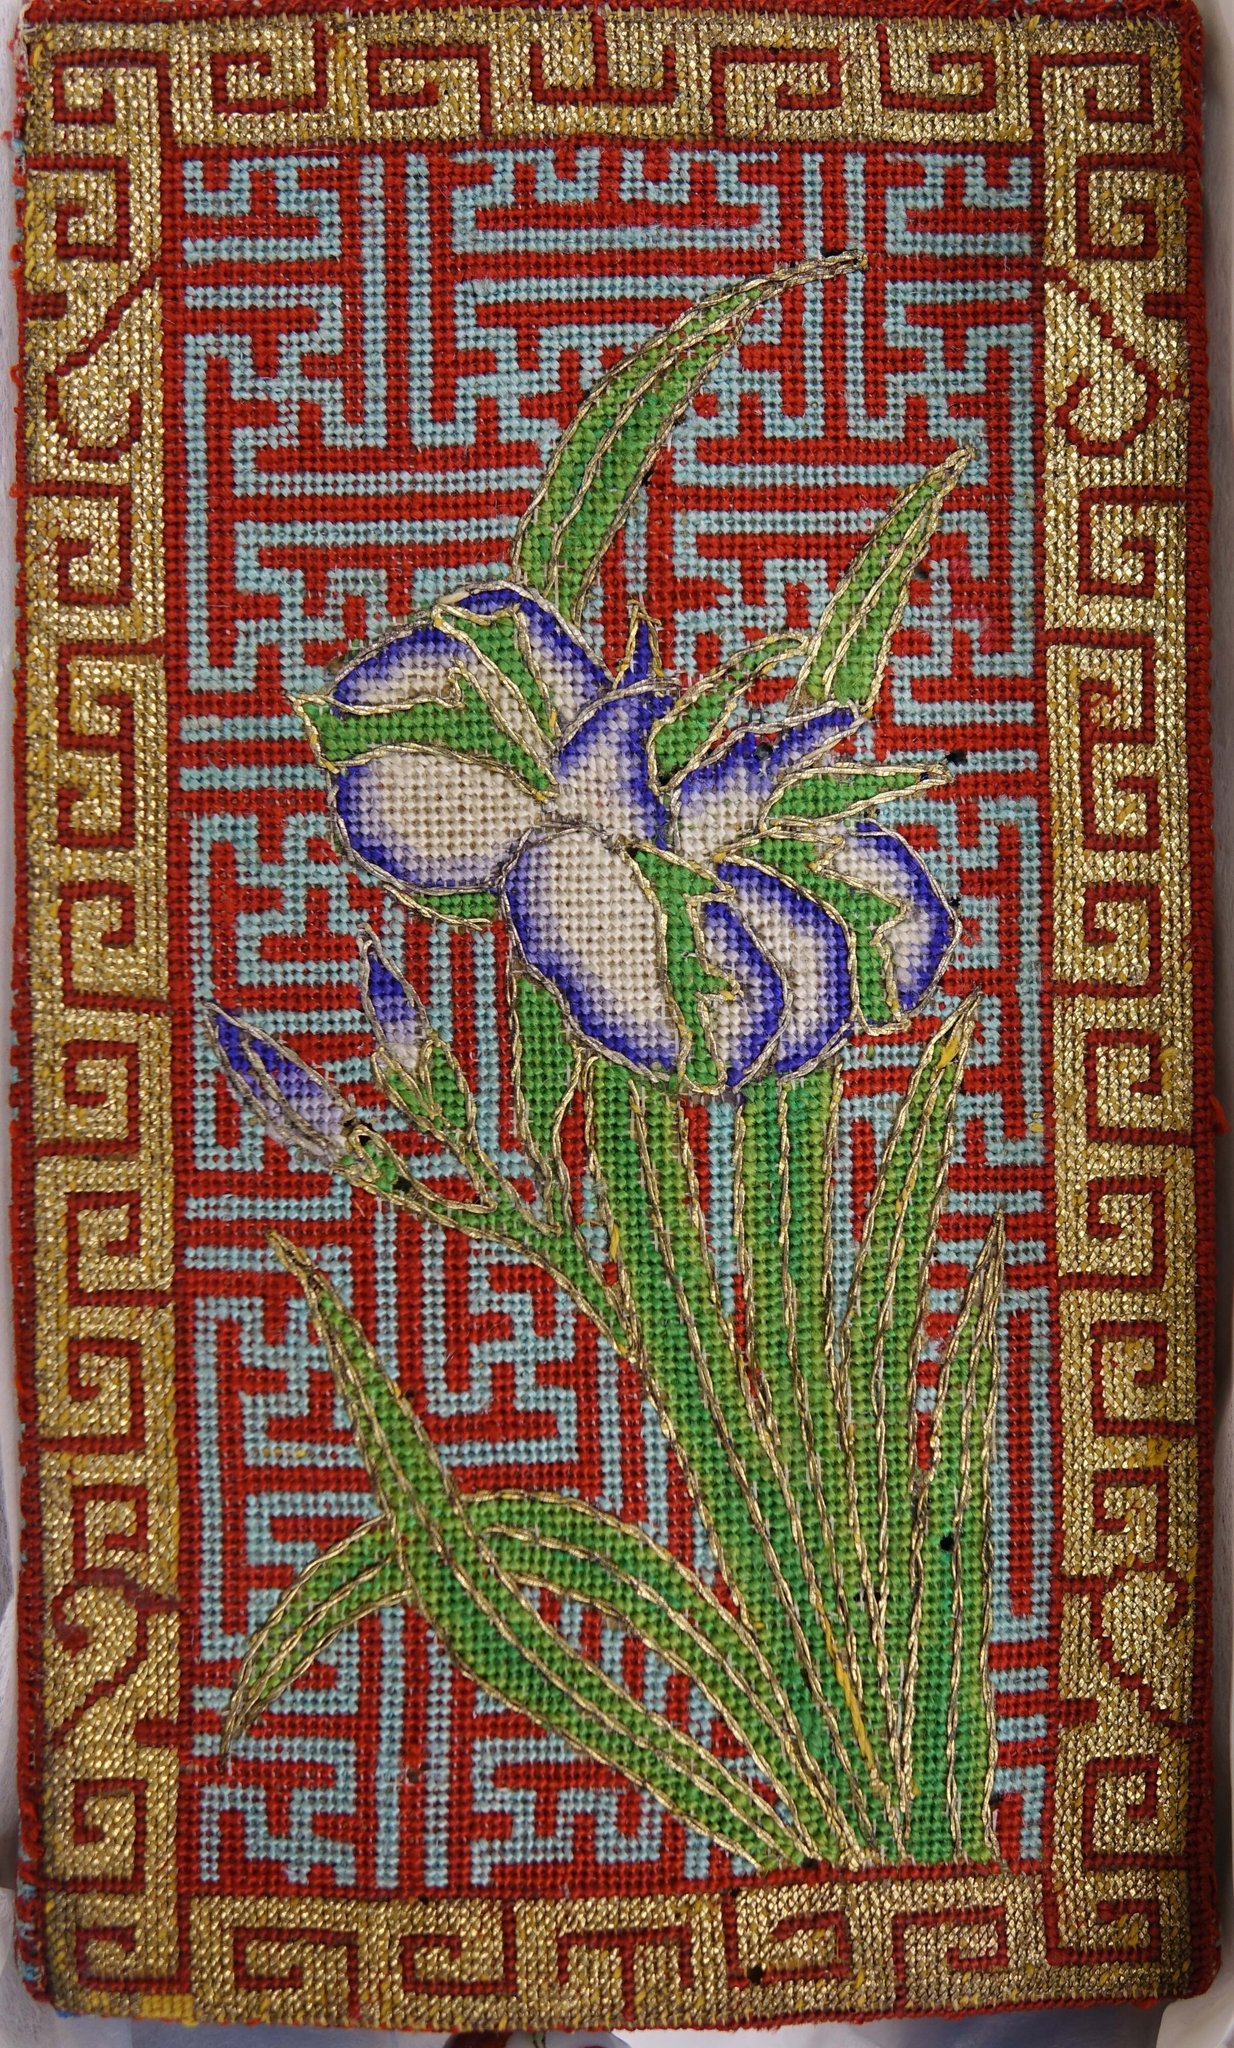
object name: case, card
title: Card Case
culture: chinese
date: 1701-1900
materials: gold, porcelain, silk